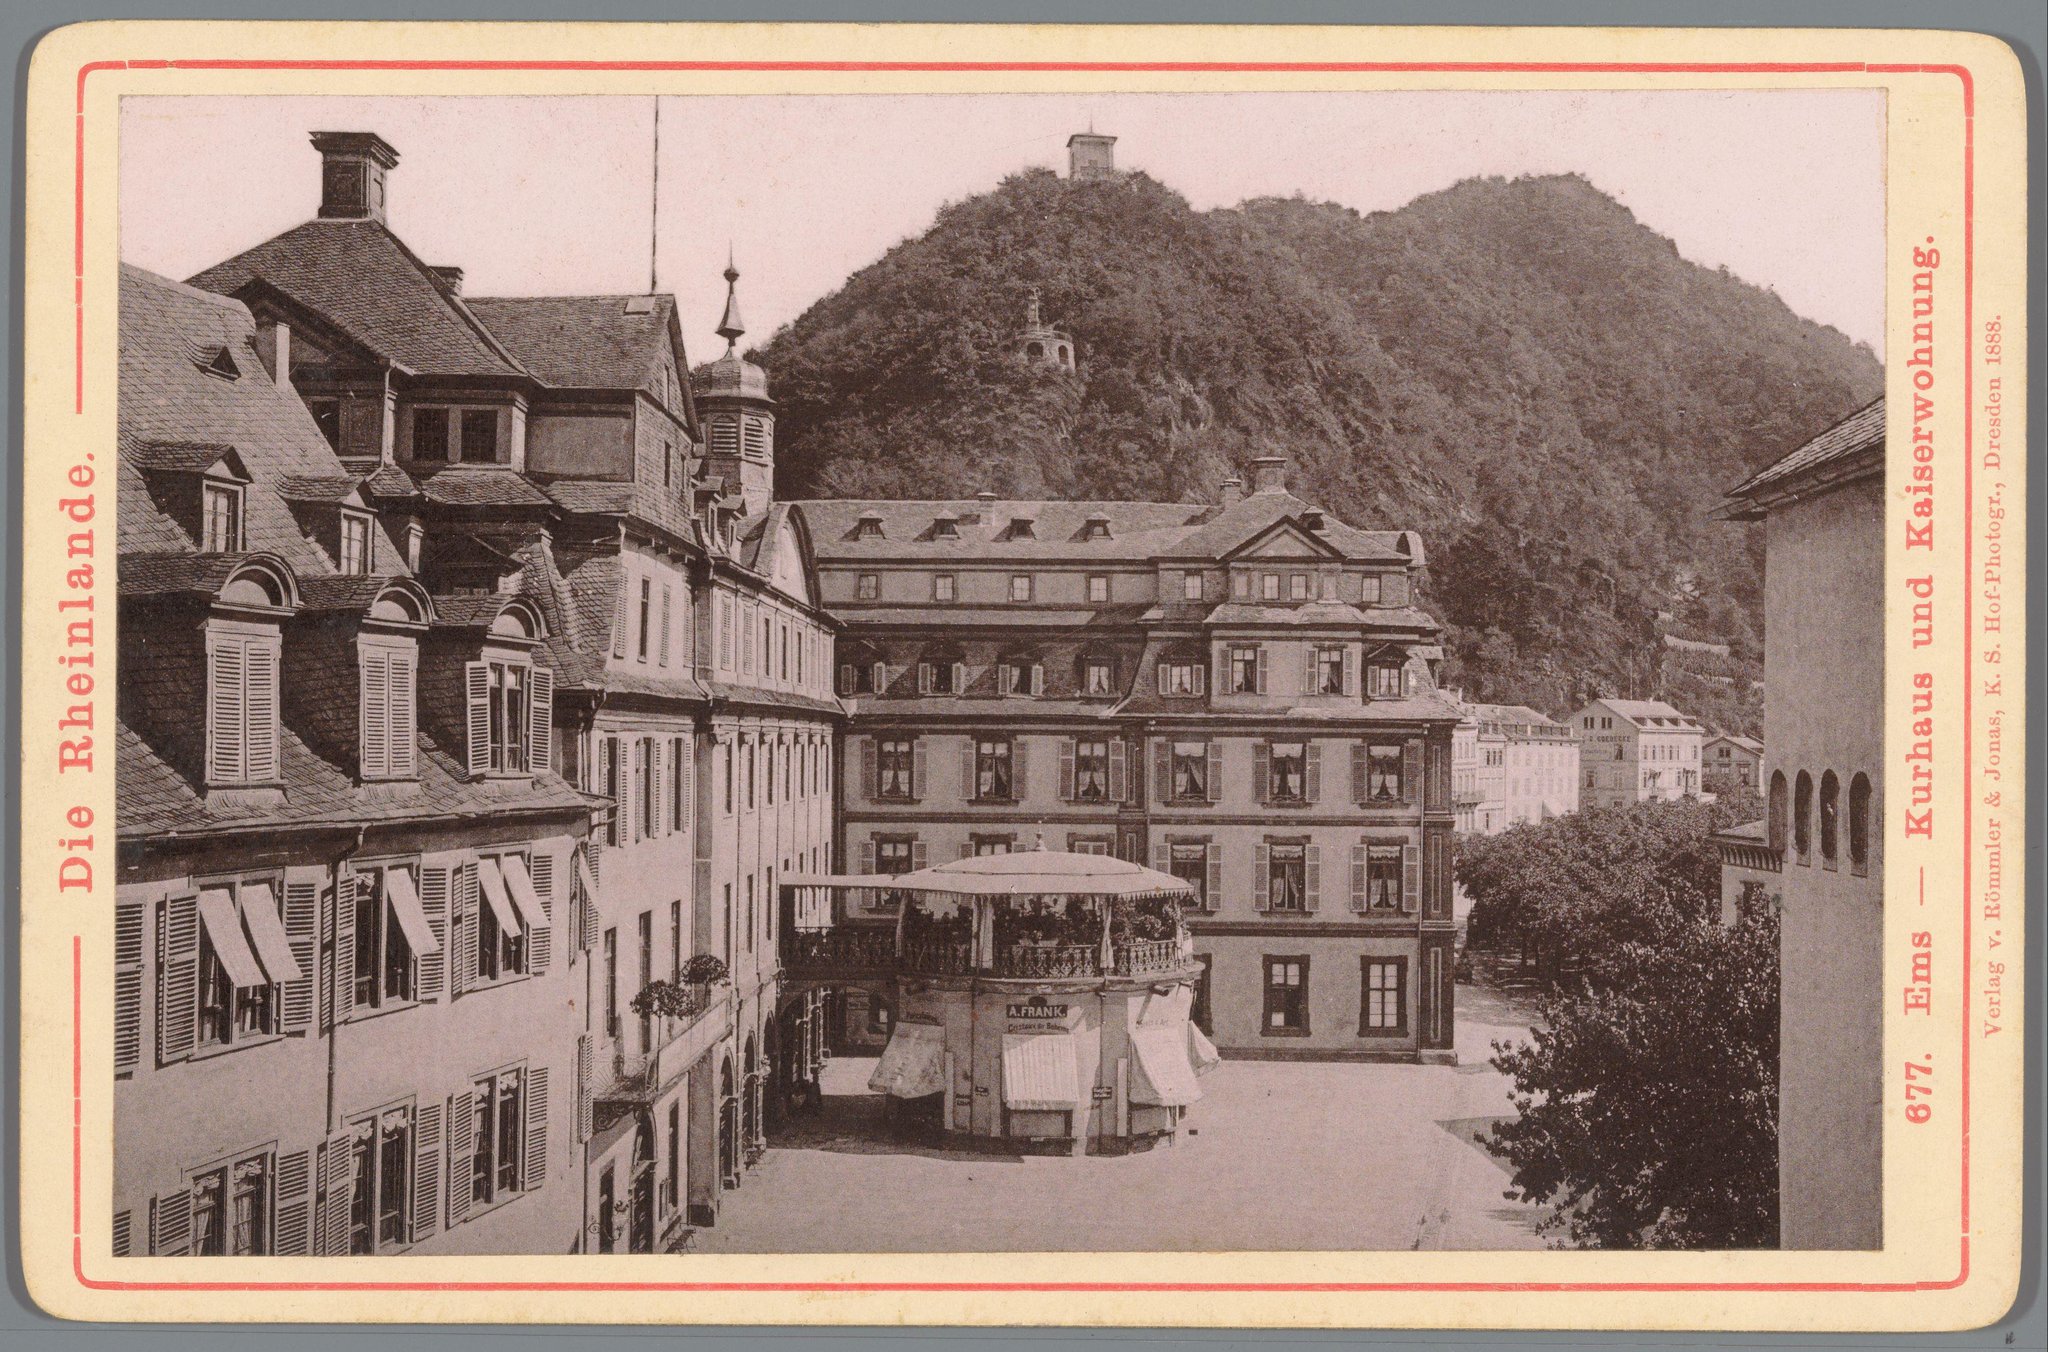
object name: cabinet photograph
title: Gezicht op een kuuroord aan een plein in Bad Ems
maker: Anonymous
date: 1888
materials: cardboard, paper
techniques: photograph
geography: dresden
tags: square, place, circus, etc., palace, watering-place, spa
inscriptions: number: ‘677.’, name: ‘Vosmaer’